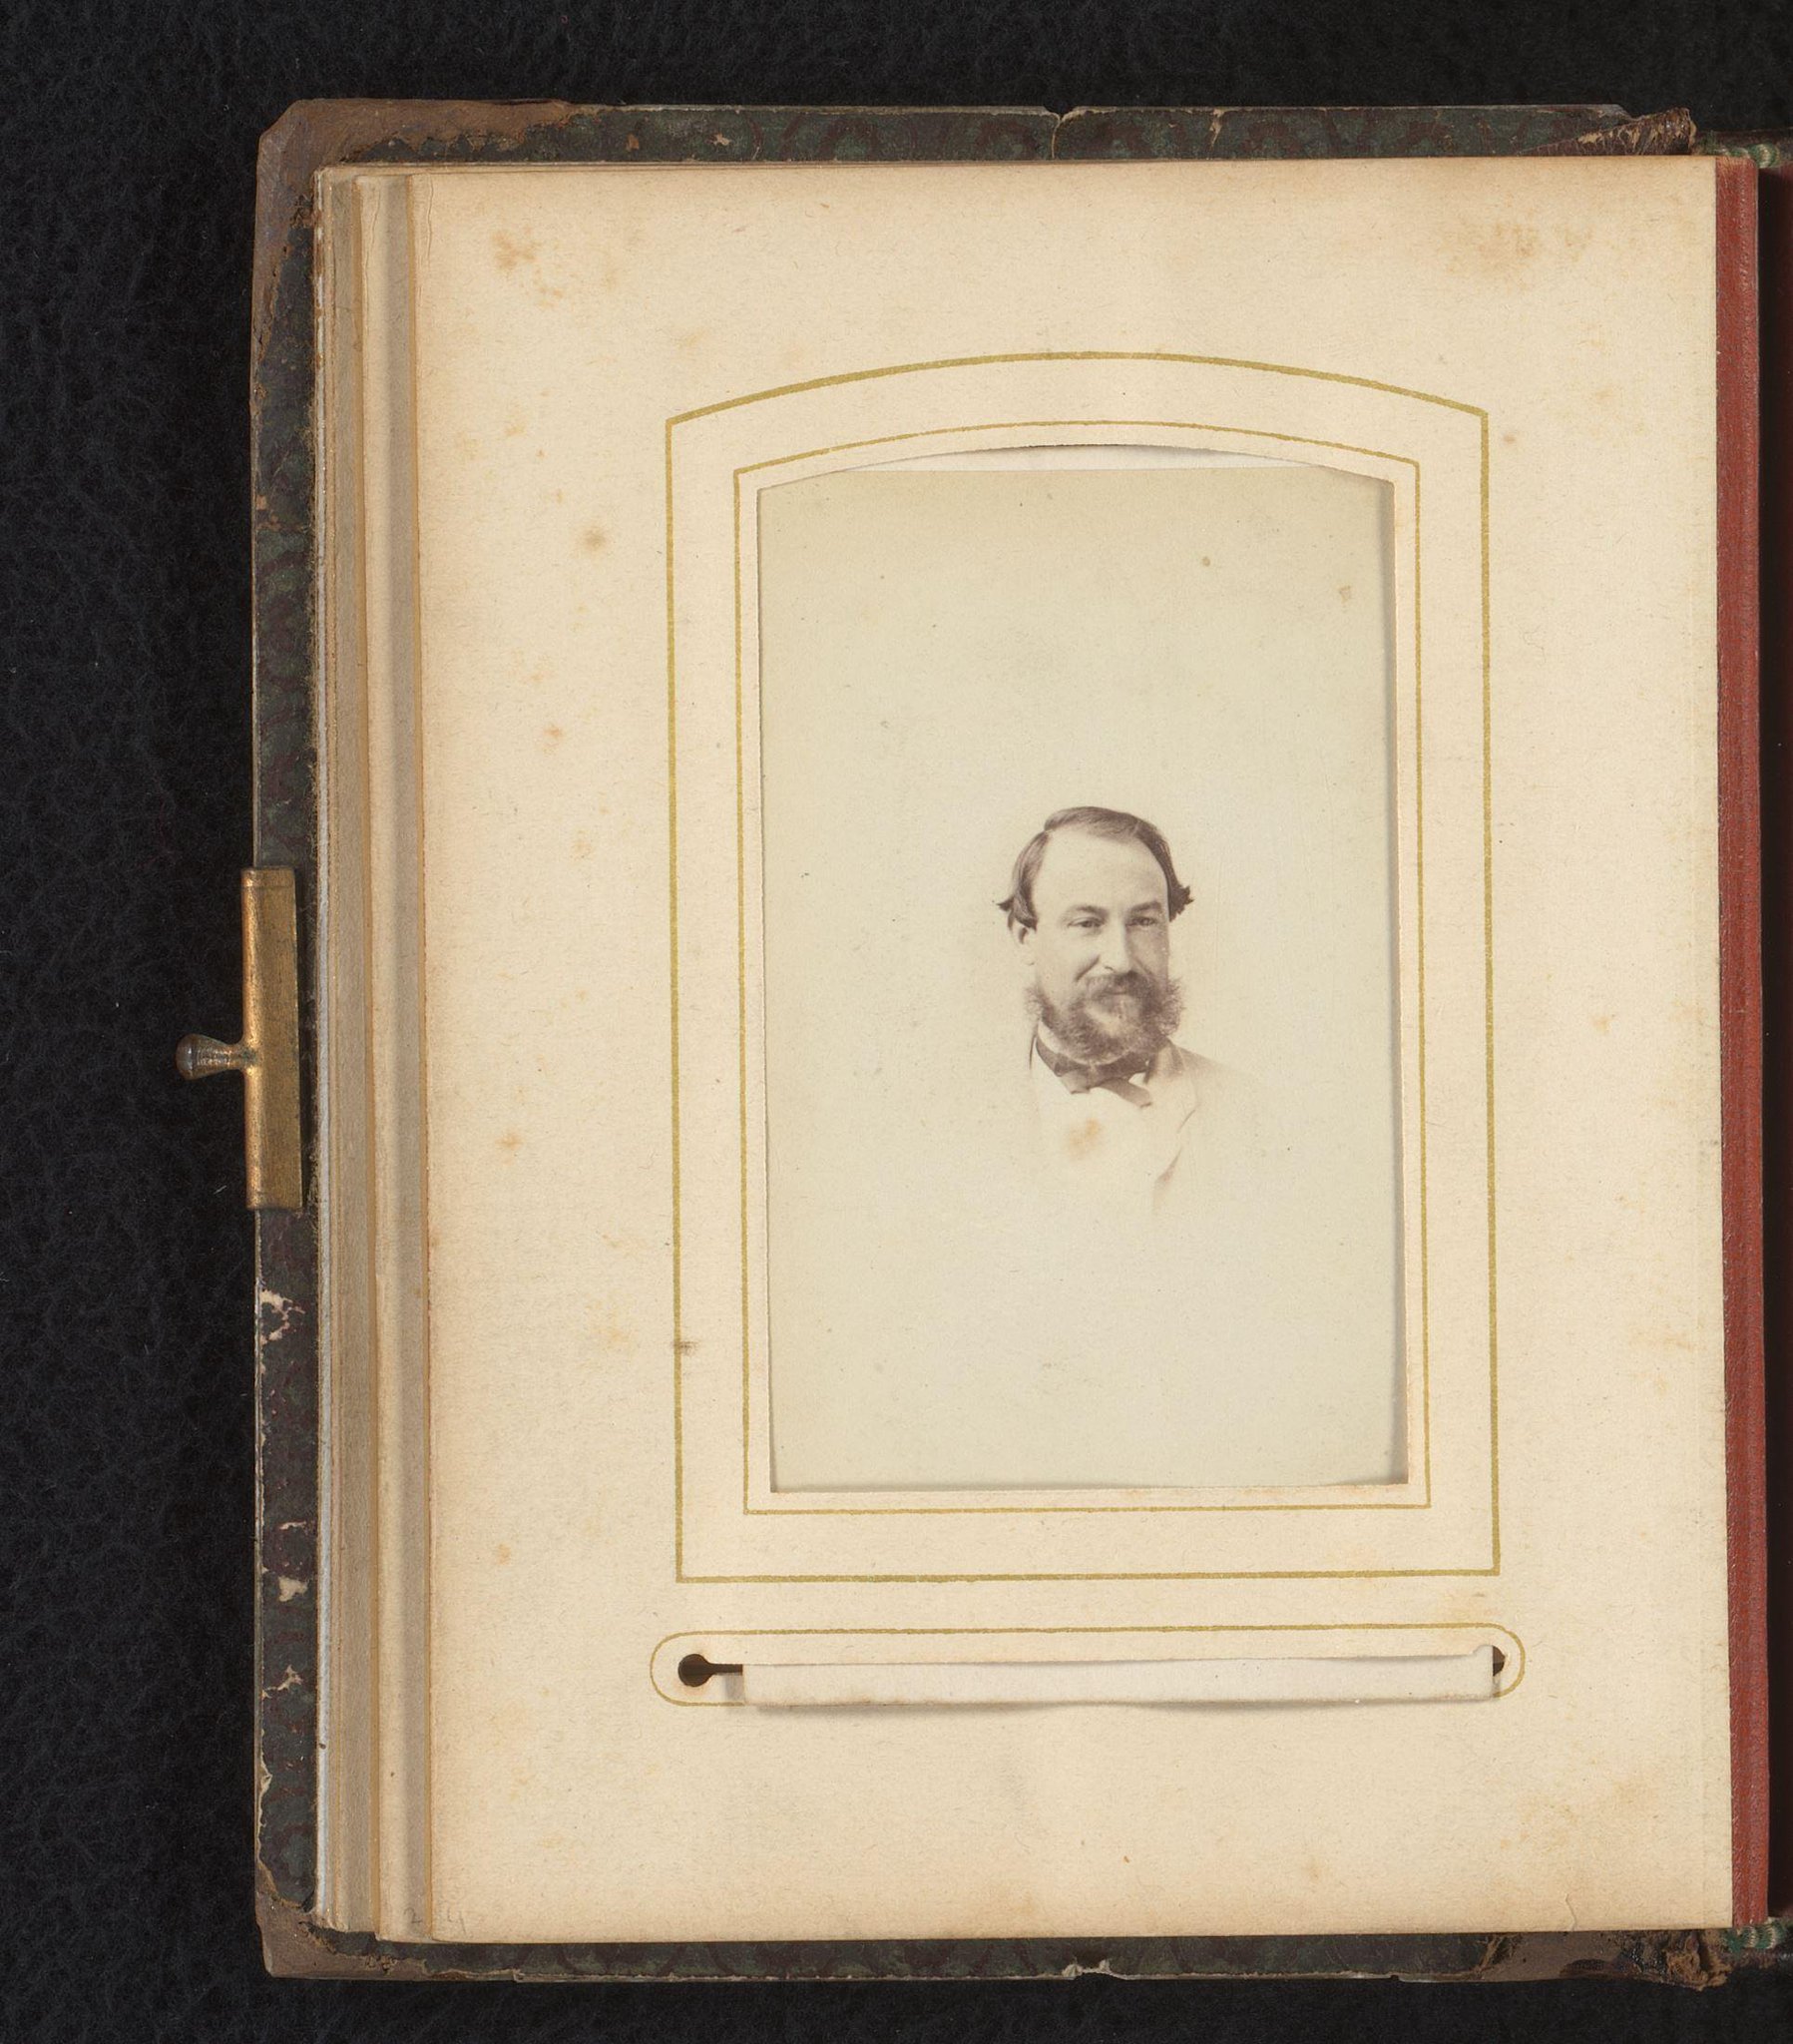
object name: carte de visite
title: Portret van een man met baard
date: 1862-1870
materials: cardboard, photographic support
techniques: albumen print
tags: adult man, historical persons, beard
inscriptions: inscription: ‘Dixey & Co./ Brighton/ 23, Ship Street’